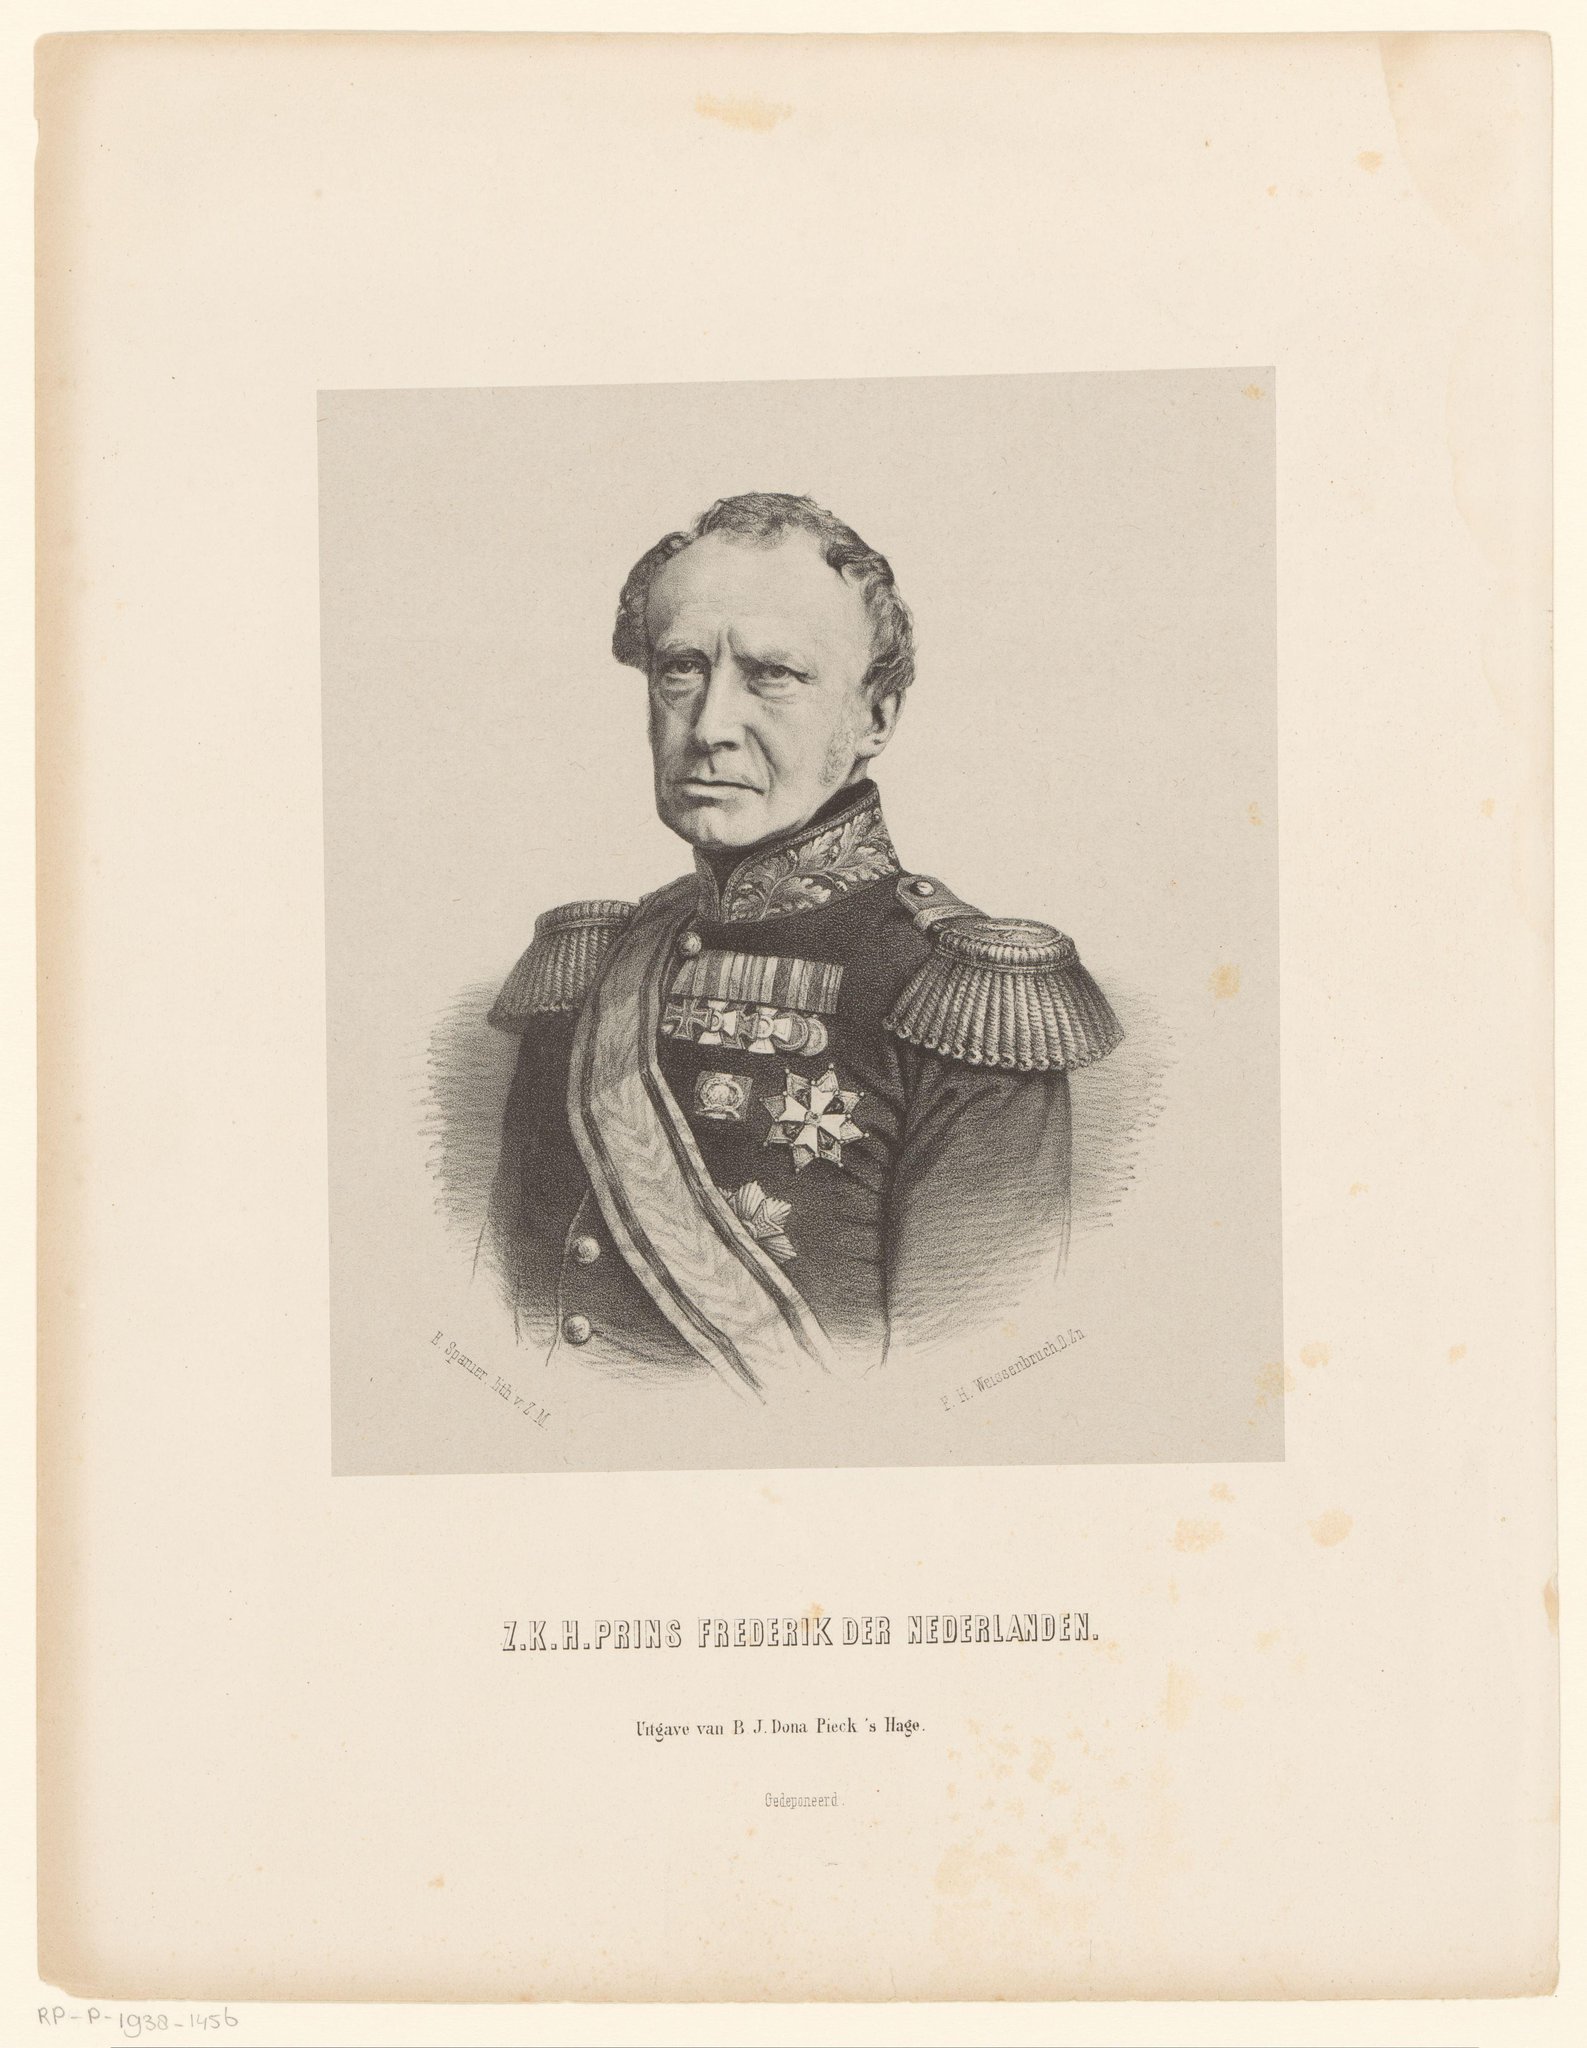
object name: print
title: Z.K.H. prins Frederik der Nederlanden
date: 1858-1863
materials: paper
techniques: lithograph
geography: the hague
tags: frederik van oranje-nassau, historical persons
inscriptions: collector's mark: Lugt 2228, : ‘Gedeponeerd.’